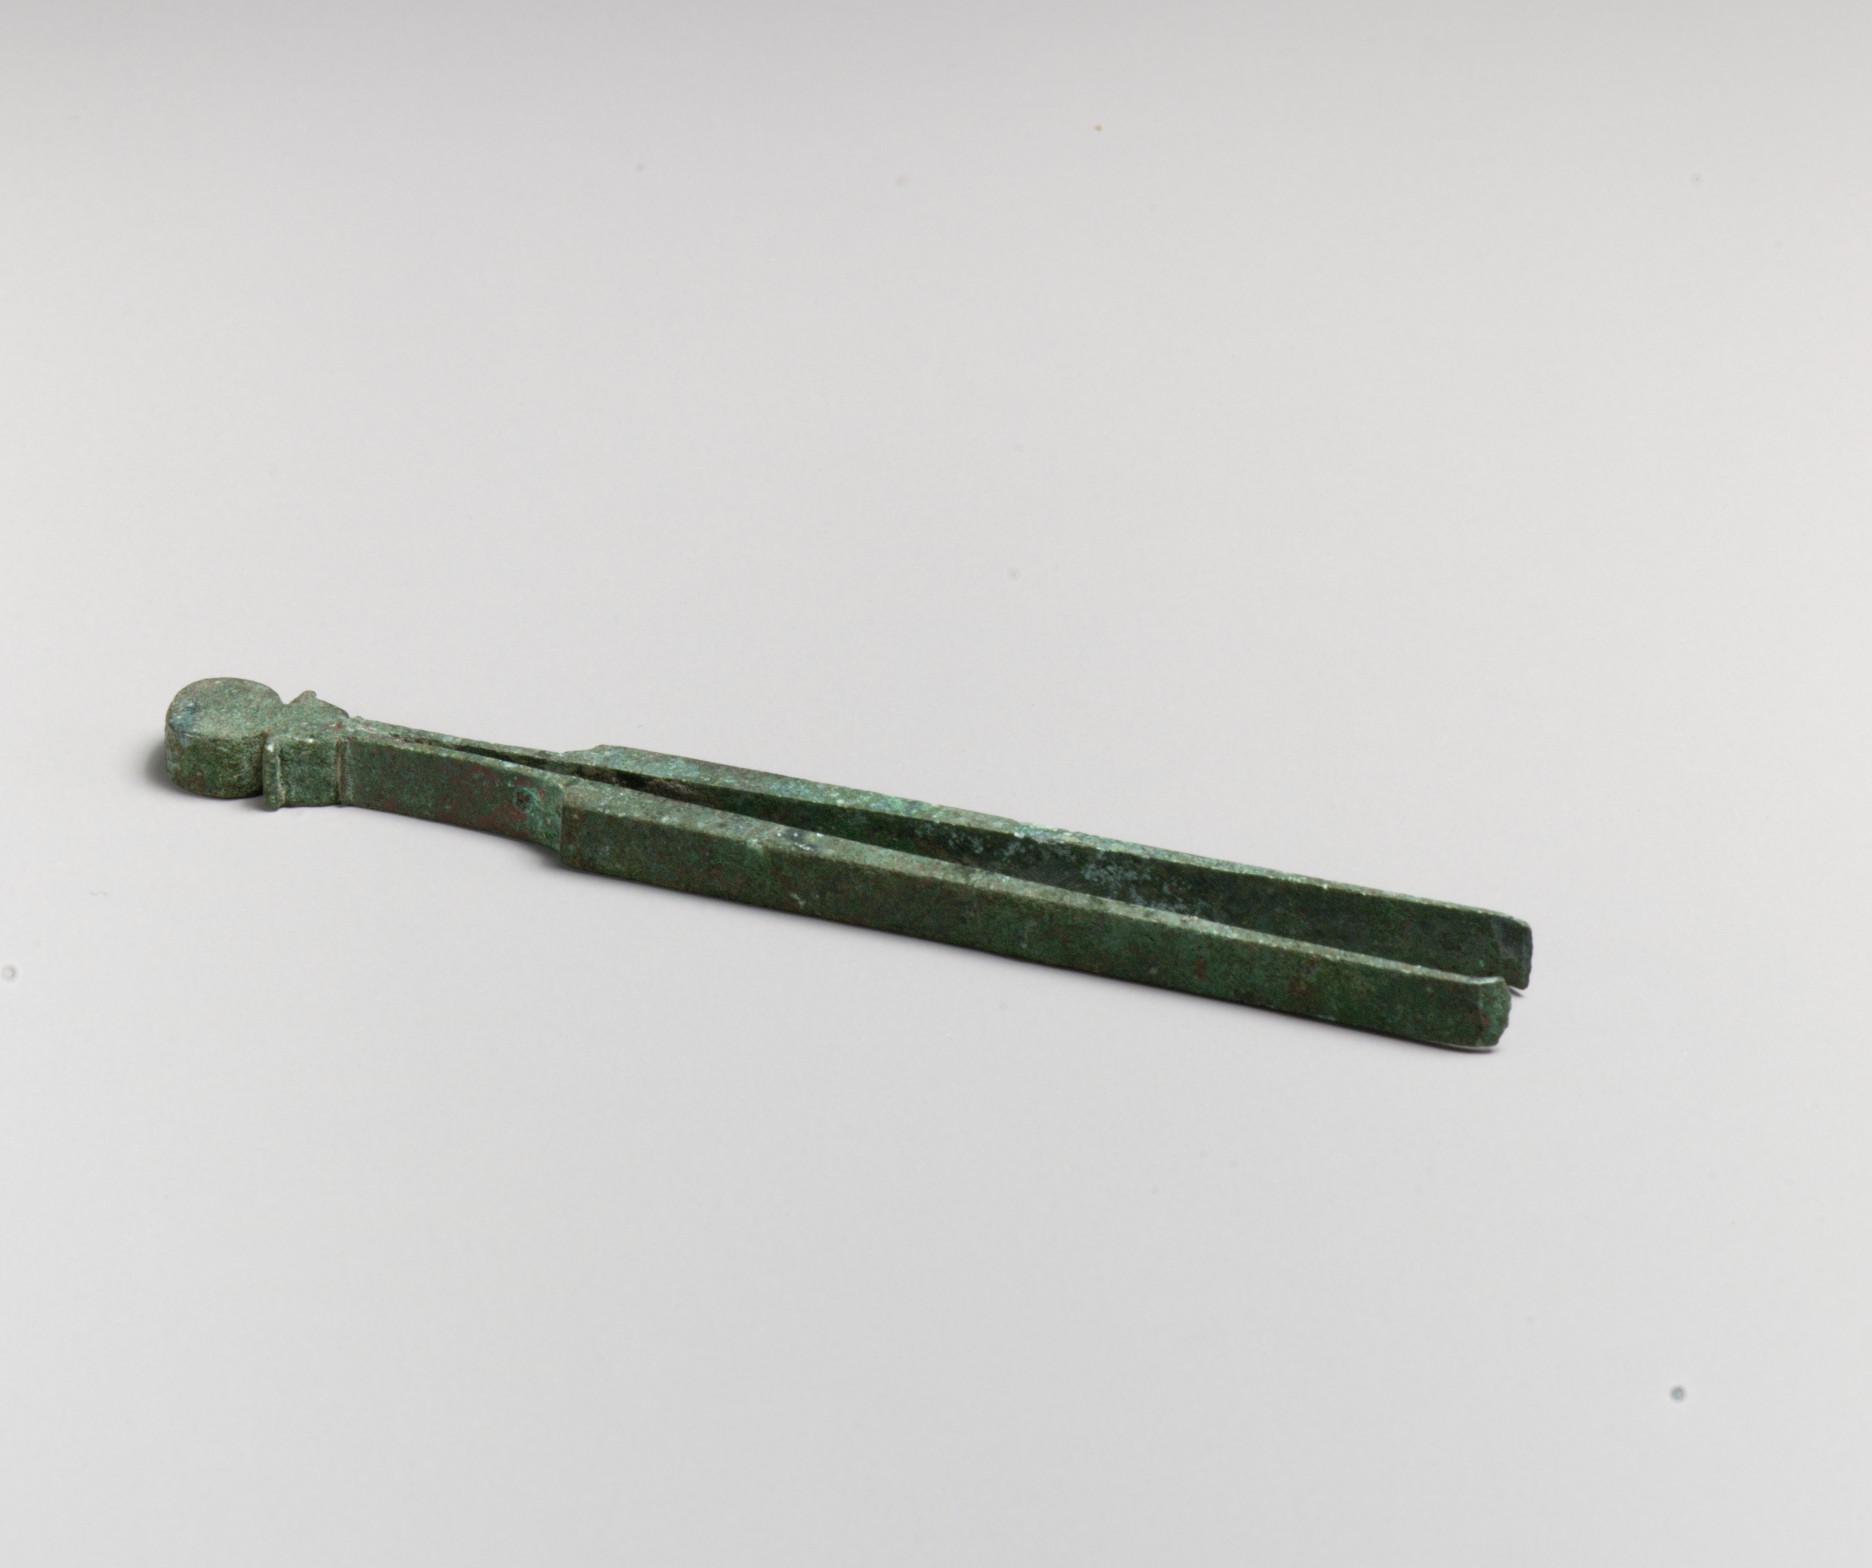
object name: tweezer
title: Bronze tweezers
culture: roman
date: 1-200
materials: bronze